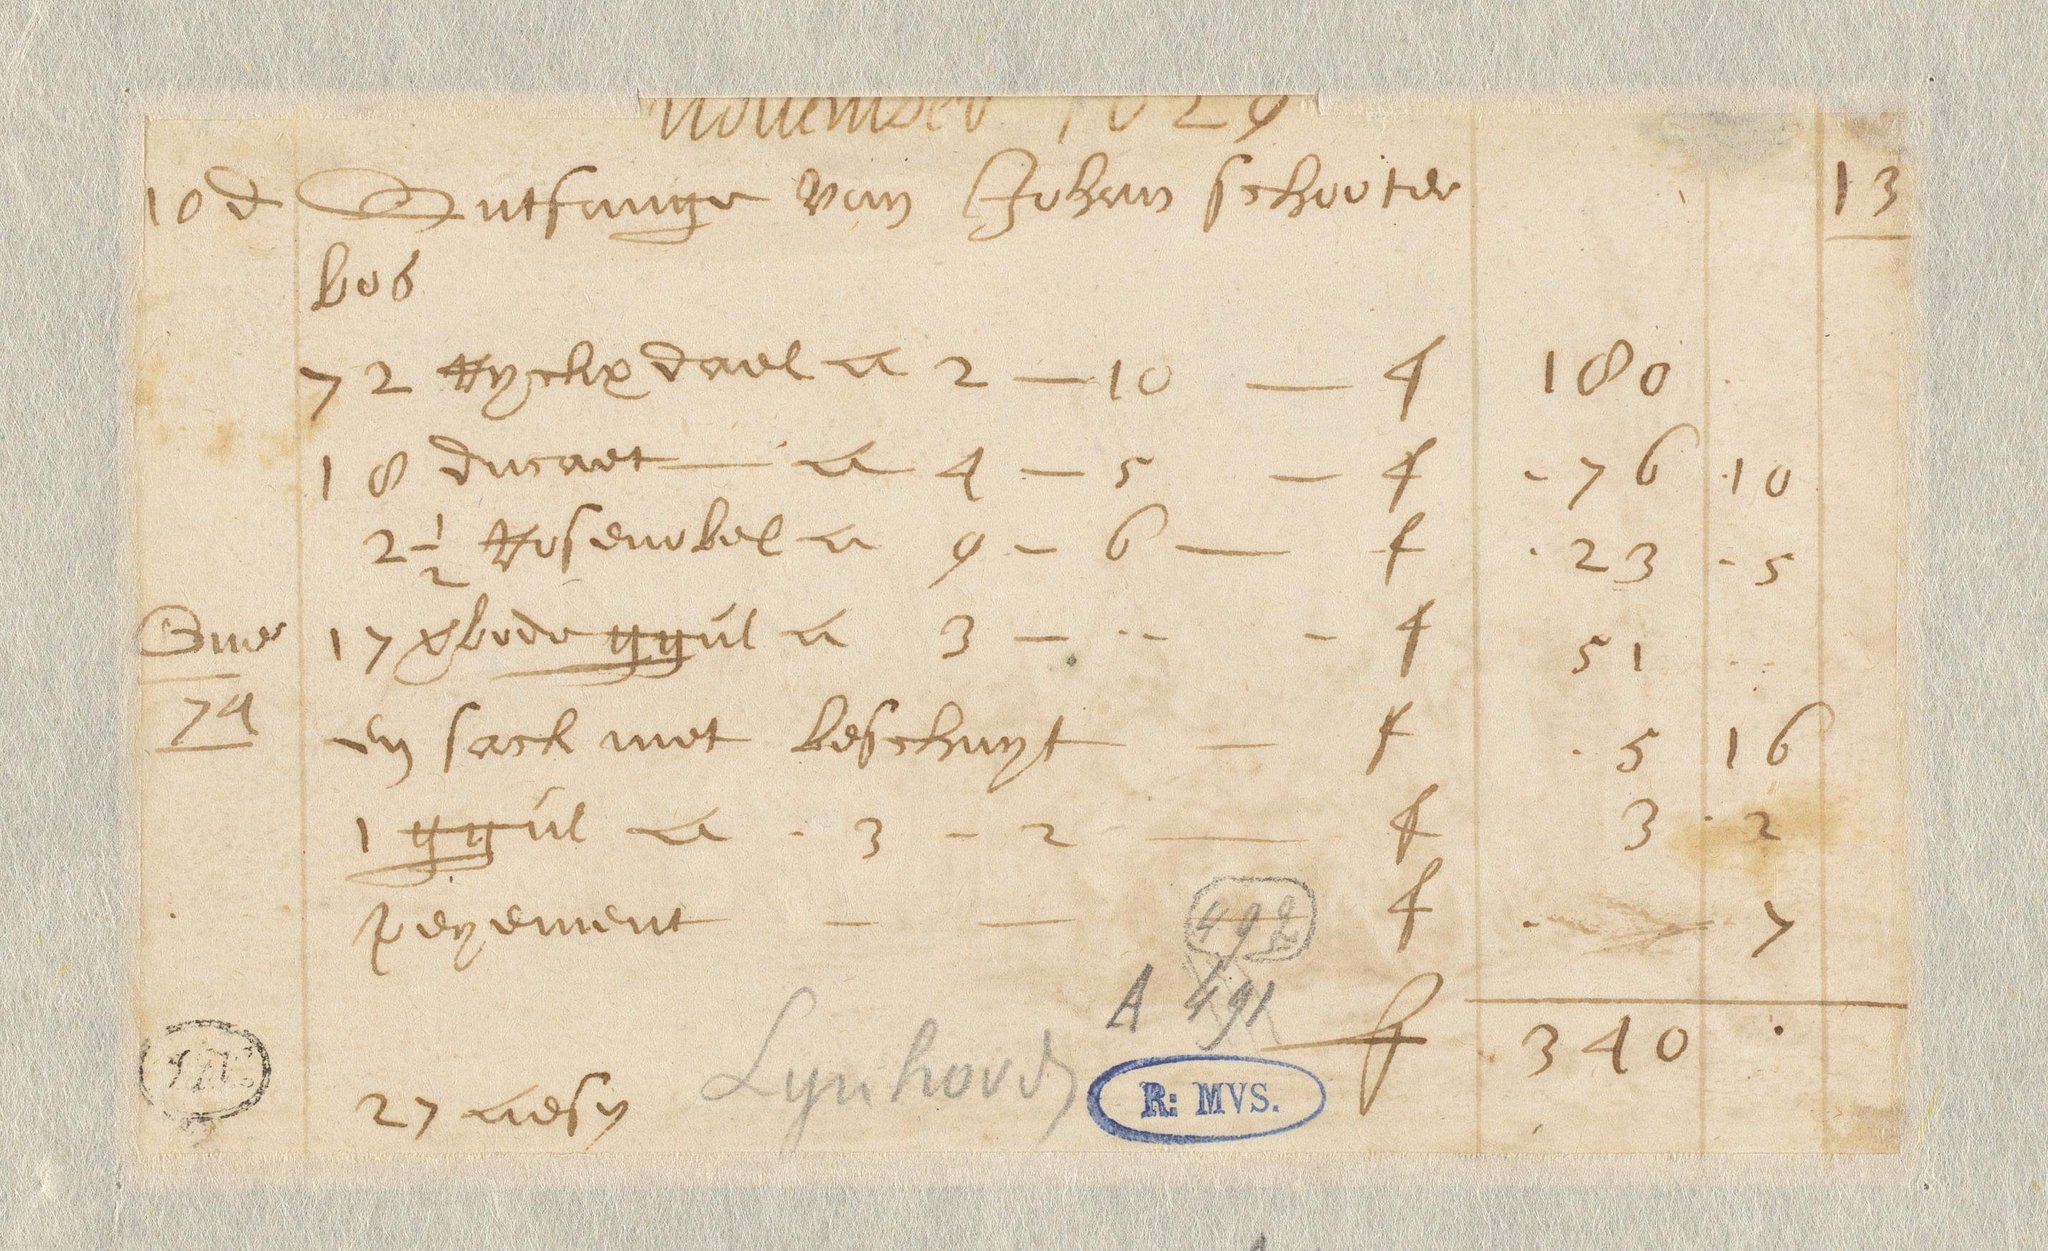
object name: tekst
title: Prijslijst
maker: nicolaes van lijnhoven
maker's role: draughtsman, print maker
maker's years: -1702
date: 1639-1702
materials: ink, paper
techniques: pen